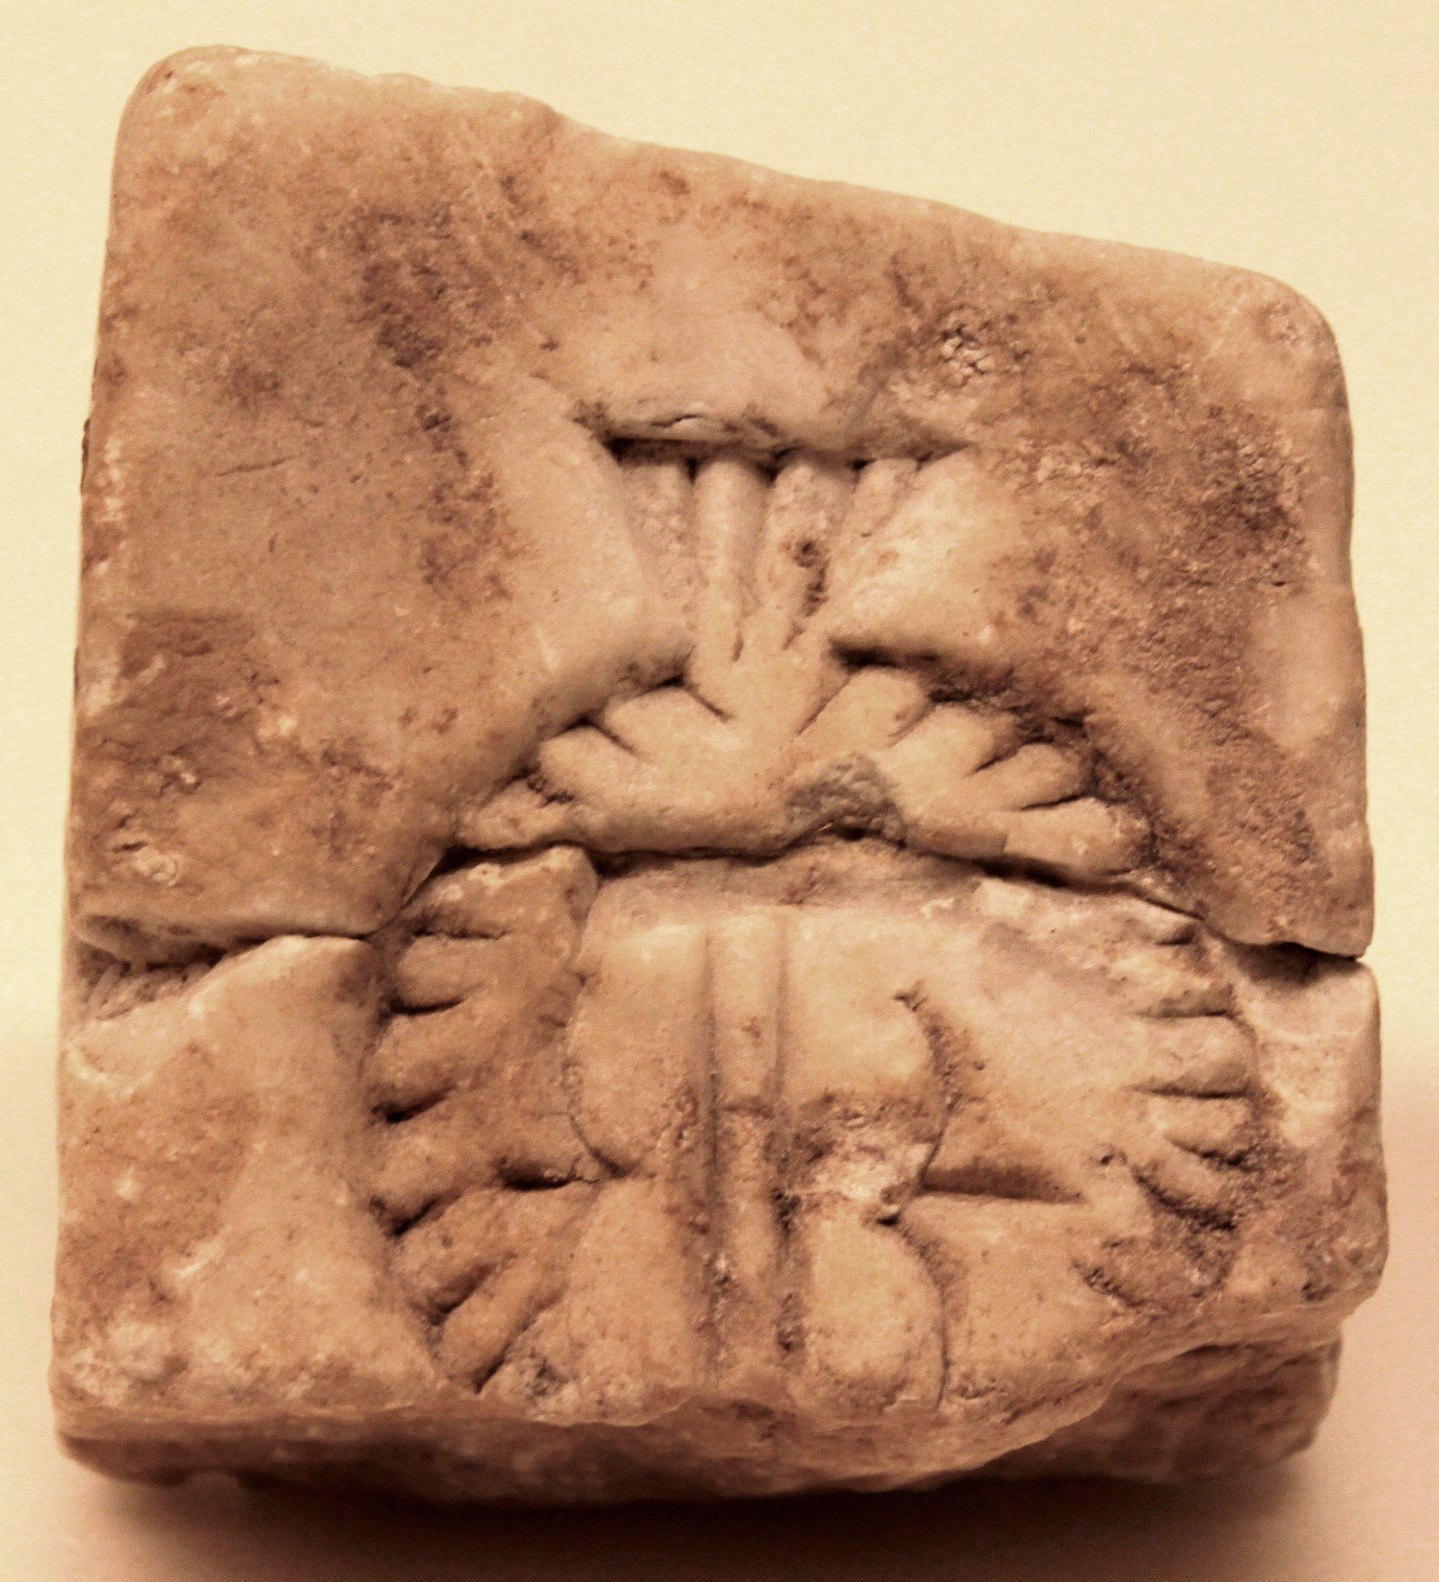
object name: stone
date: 701-1200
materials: stone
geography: iran